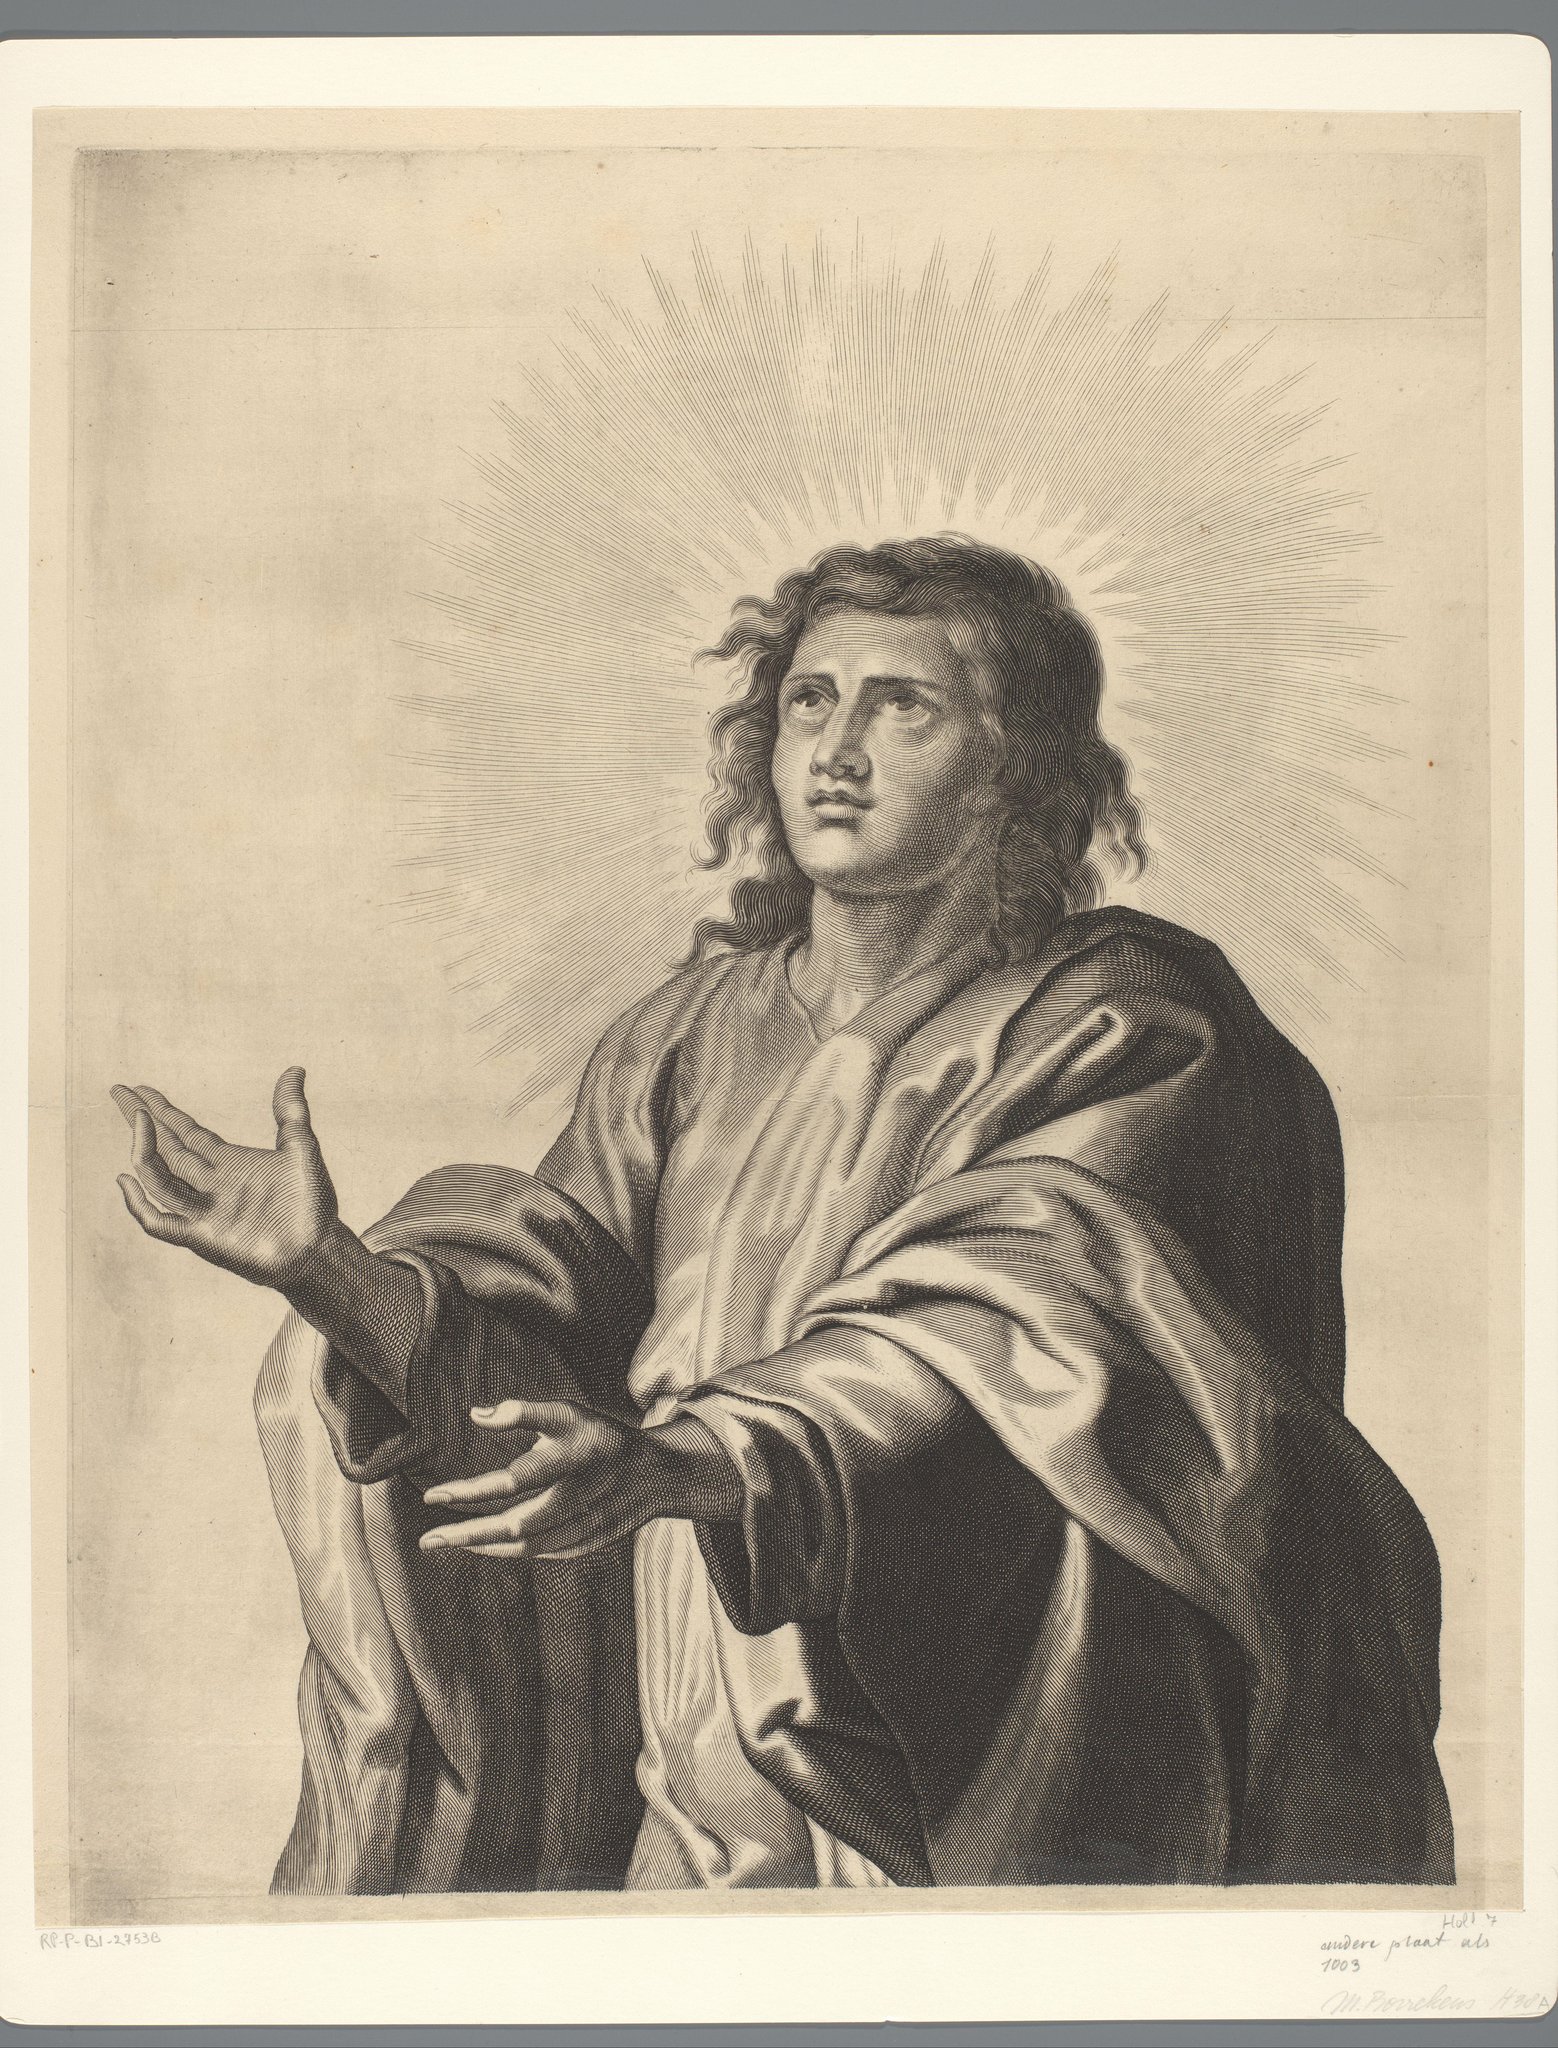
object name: print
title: Johannes de Evangelist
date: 1625-1670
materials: paper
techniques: engraving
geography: antwerp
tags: the apostle john the evangelist; possible attributes: book, cauldron, chalice with snake, eagle, palm, scroll, prospect of city, town panorama, silhouette of city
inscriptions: collector's mark: Lugt 240 of 1838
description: Bovenplaat. Op de voorgrond van de prent staat Johannes de Evangelist. Zijn ogen zijn naar de hemel gericht. Op de achtergrond een stadsgezicht.